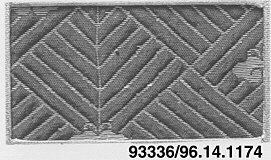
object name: piece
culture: japanese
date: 1701-1900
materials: silk